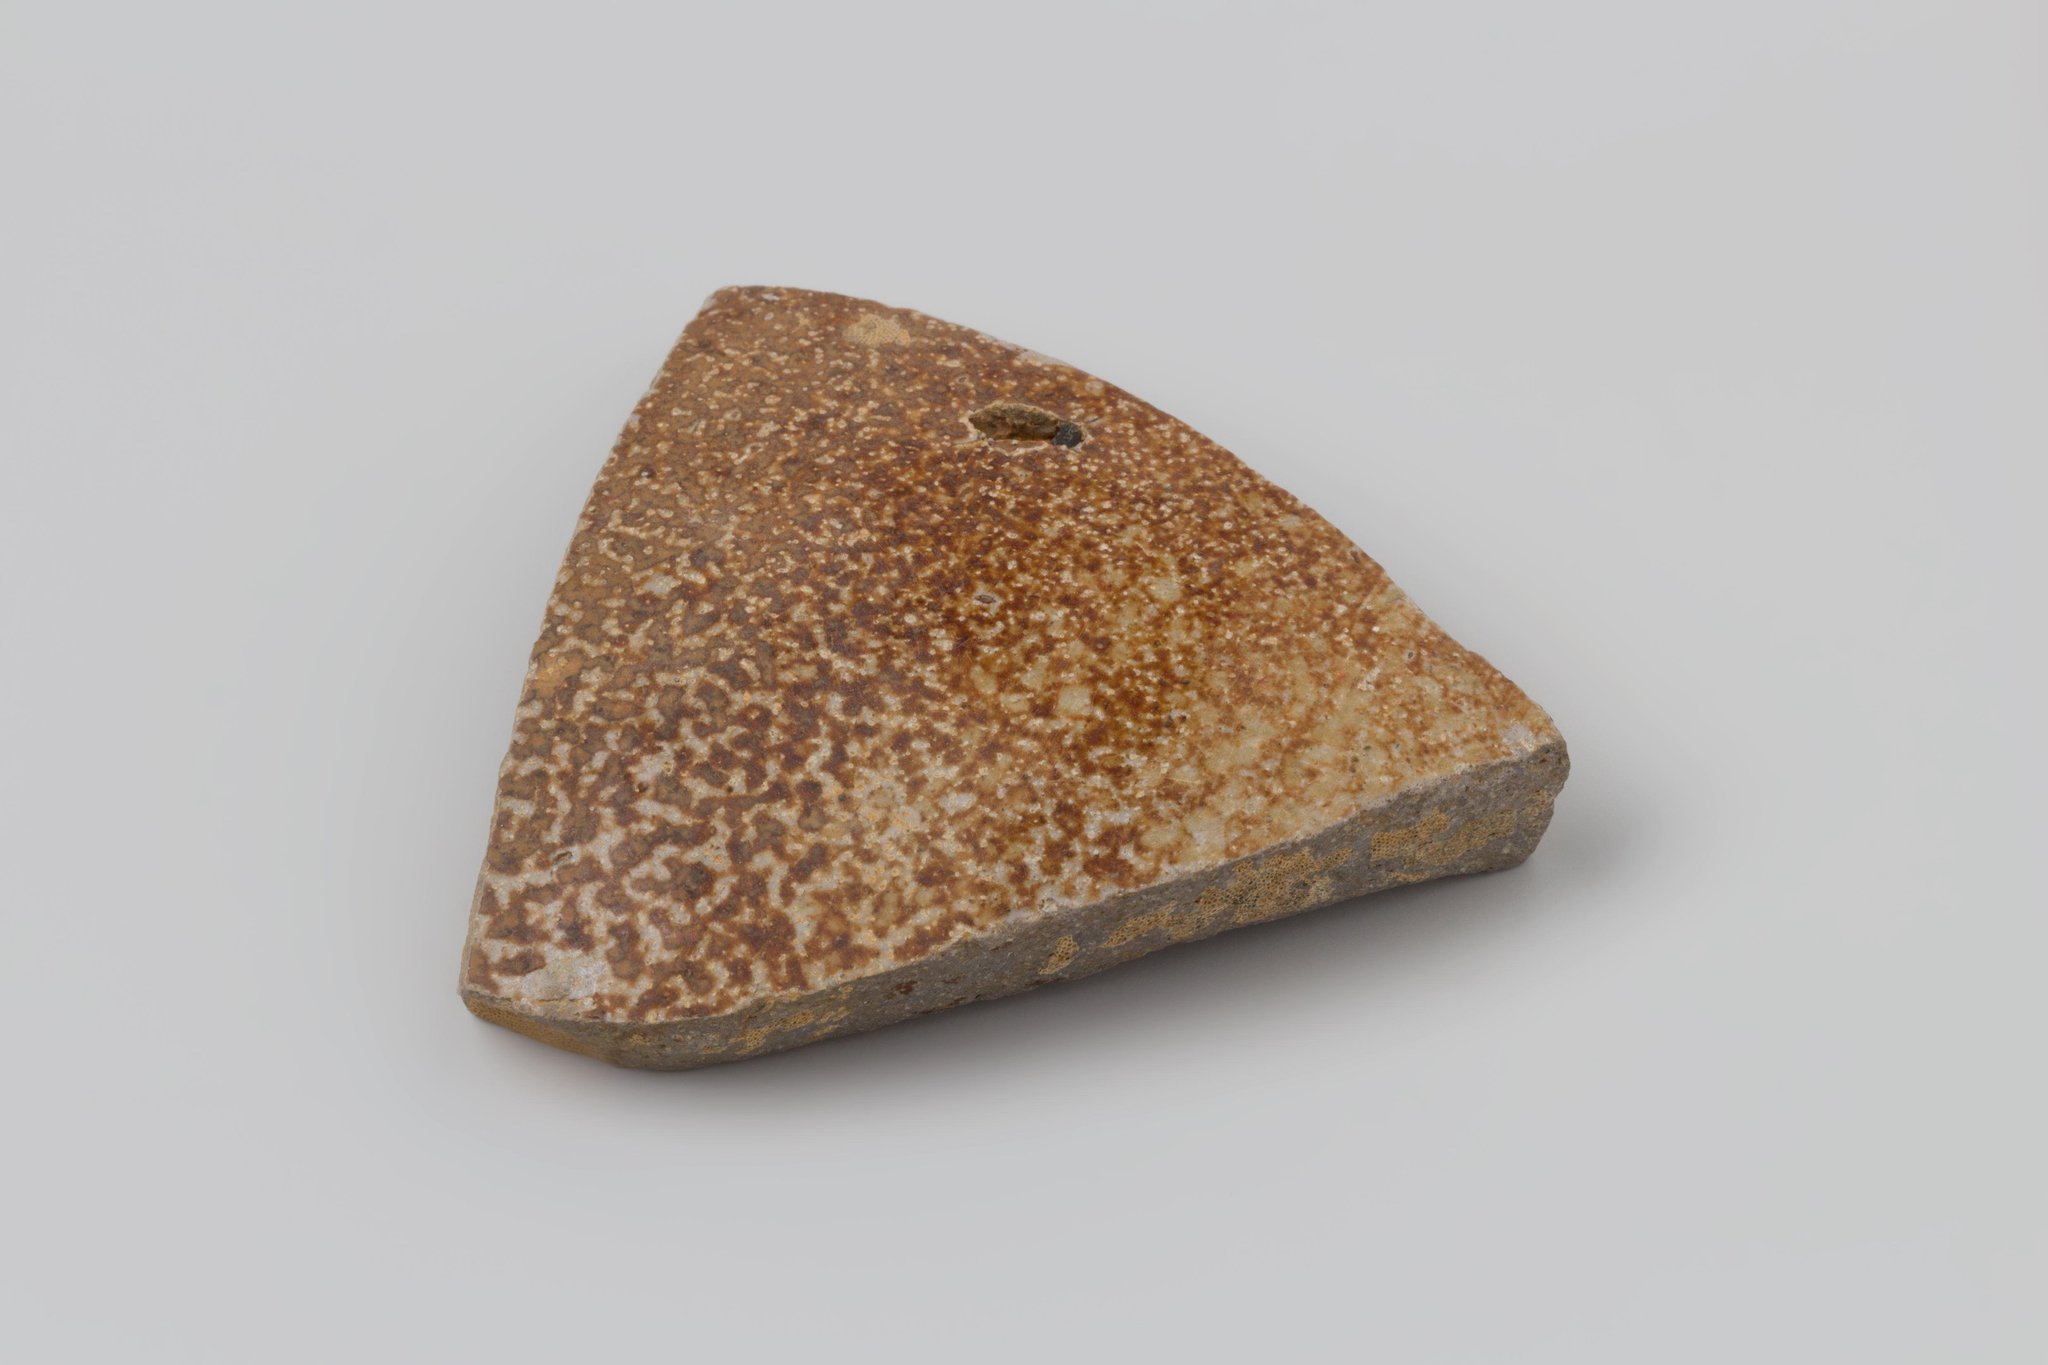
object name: ewer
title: Scherf van een kan uit het wrak van de Oost-Indiëvaarder 't Vliegend Hart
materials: stoneware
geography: netherlands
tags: 't vliegend hart (schip), verenigde oostindische compagnie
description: Eén lichtgebogen scherf die van buiten blauwbeige van kleur is met spikkels.